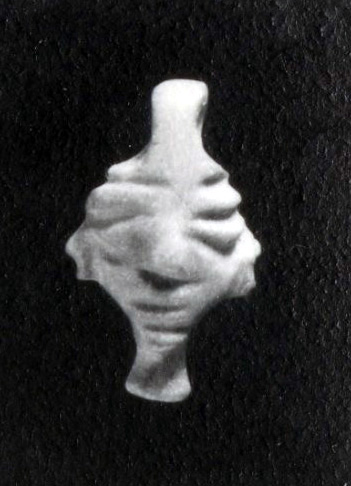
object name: amulet, face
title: Face amulet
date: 2110-2030 BCE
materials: ivory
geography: egypt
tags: faces